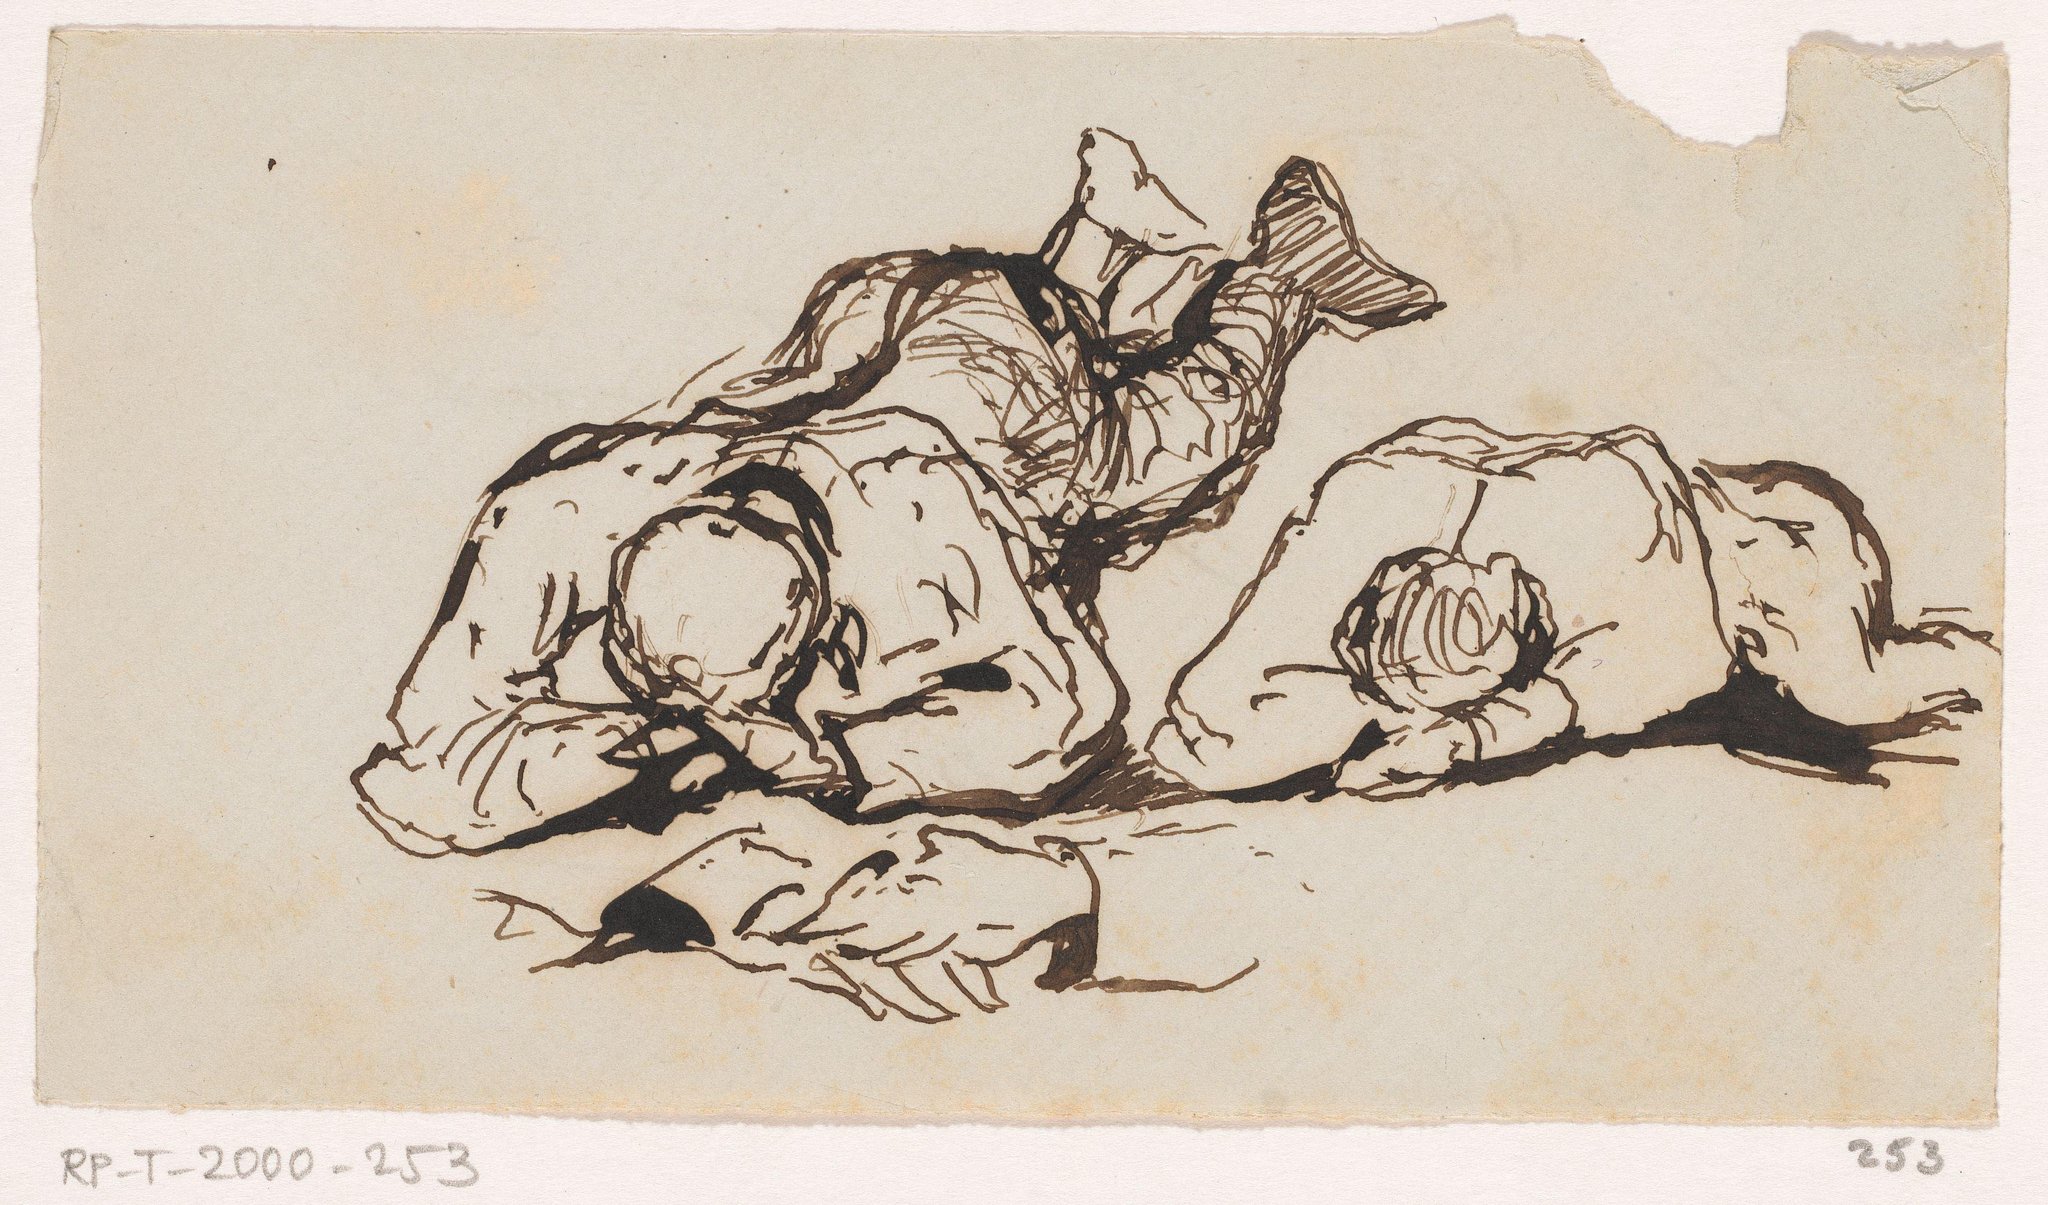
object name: drawing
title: Studies van liggende man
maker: johannes tavenraat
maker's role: draughtsman, painter, print maker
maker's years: 1809-1881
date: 1869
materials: ink, paper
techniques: pen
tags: lying face downwards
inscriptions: collector's mark: Lugt 2228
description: Studies van een liggende man. Getekend op de achterzijde van een deel van een envelop gericht aan 'Mejufrouw M J. Tavenraat', met postzegel en gedateerd 69.